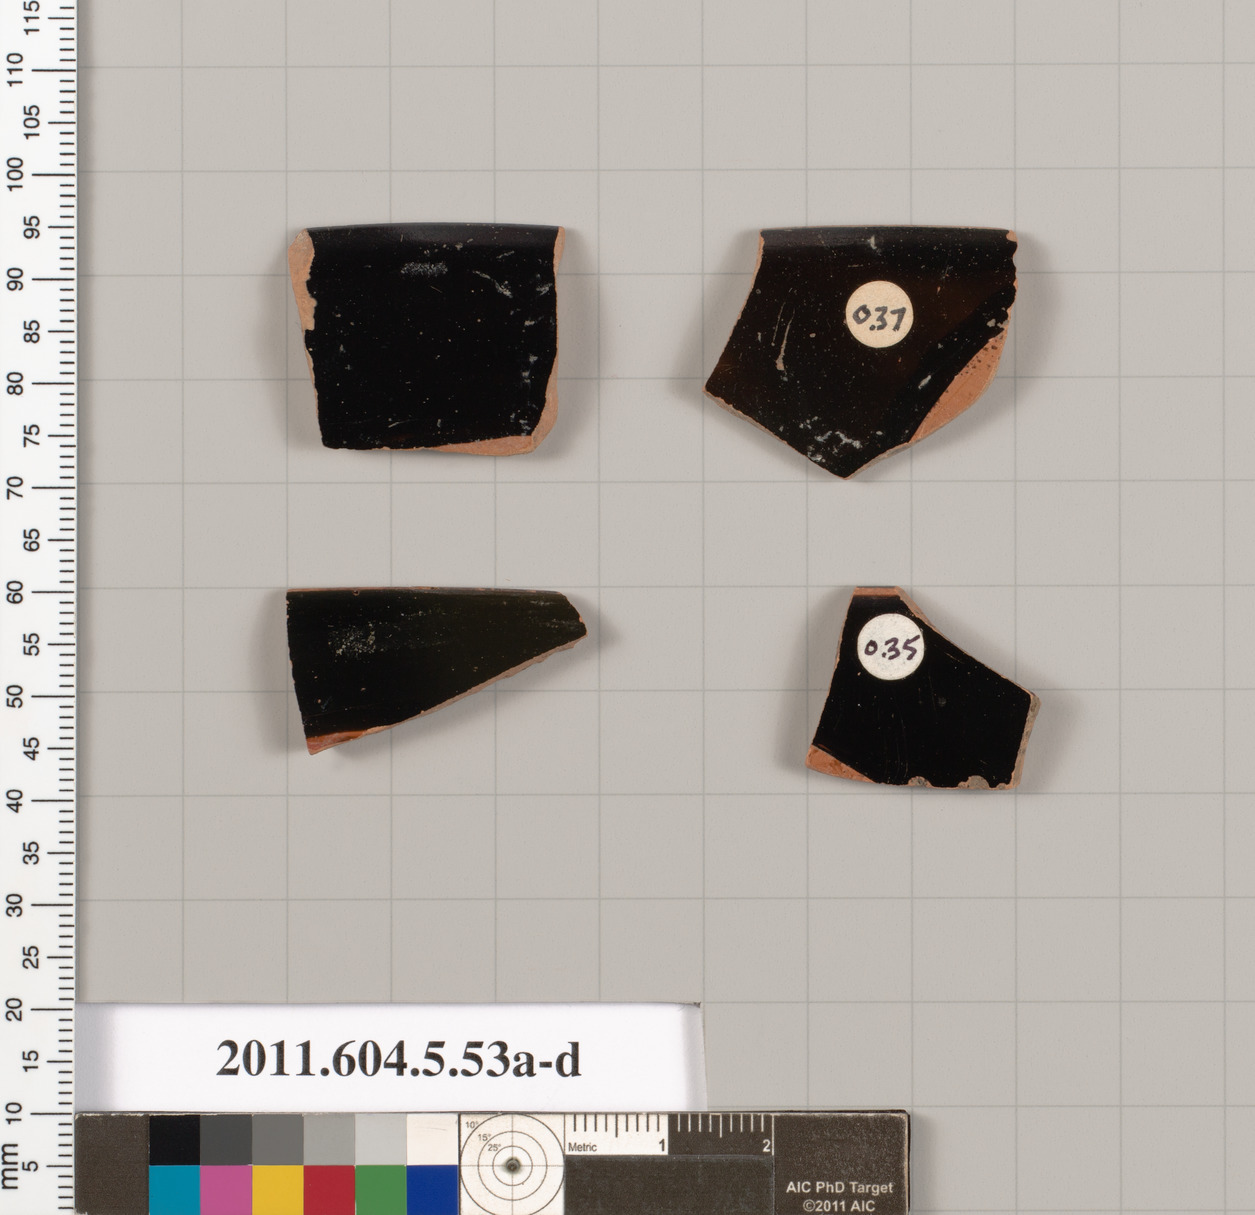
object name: kylix fragment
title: Terracotta rim fragments of kylikes (drinking cups)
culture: greek, attic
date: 500-401 BCE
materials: terracotta